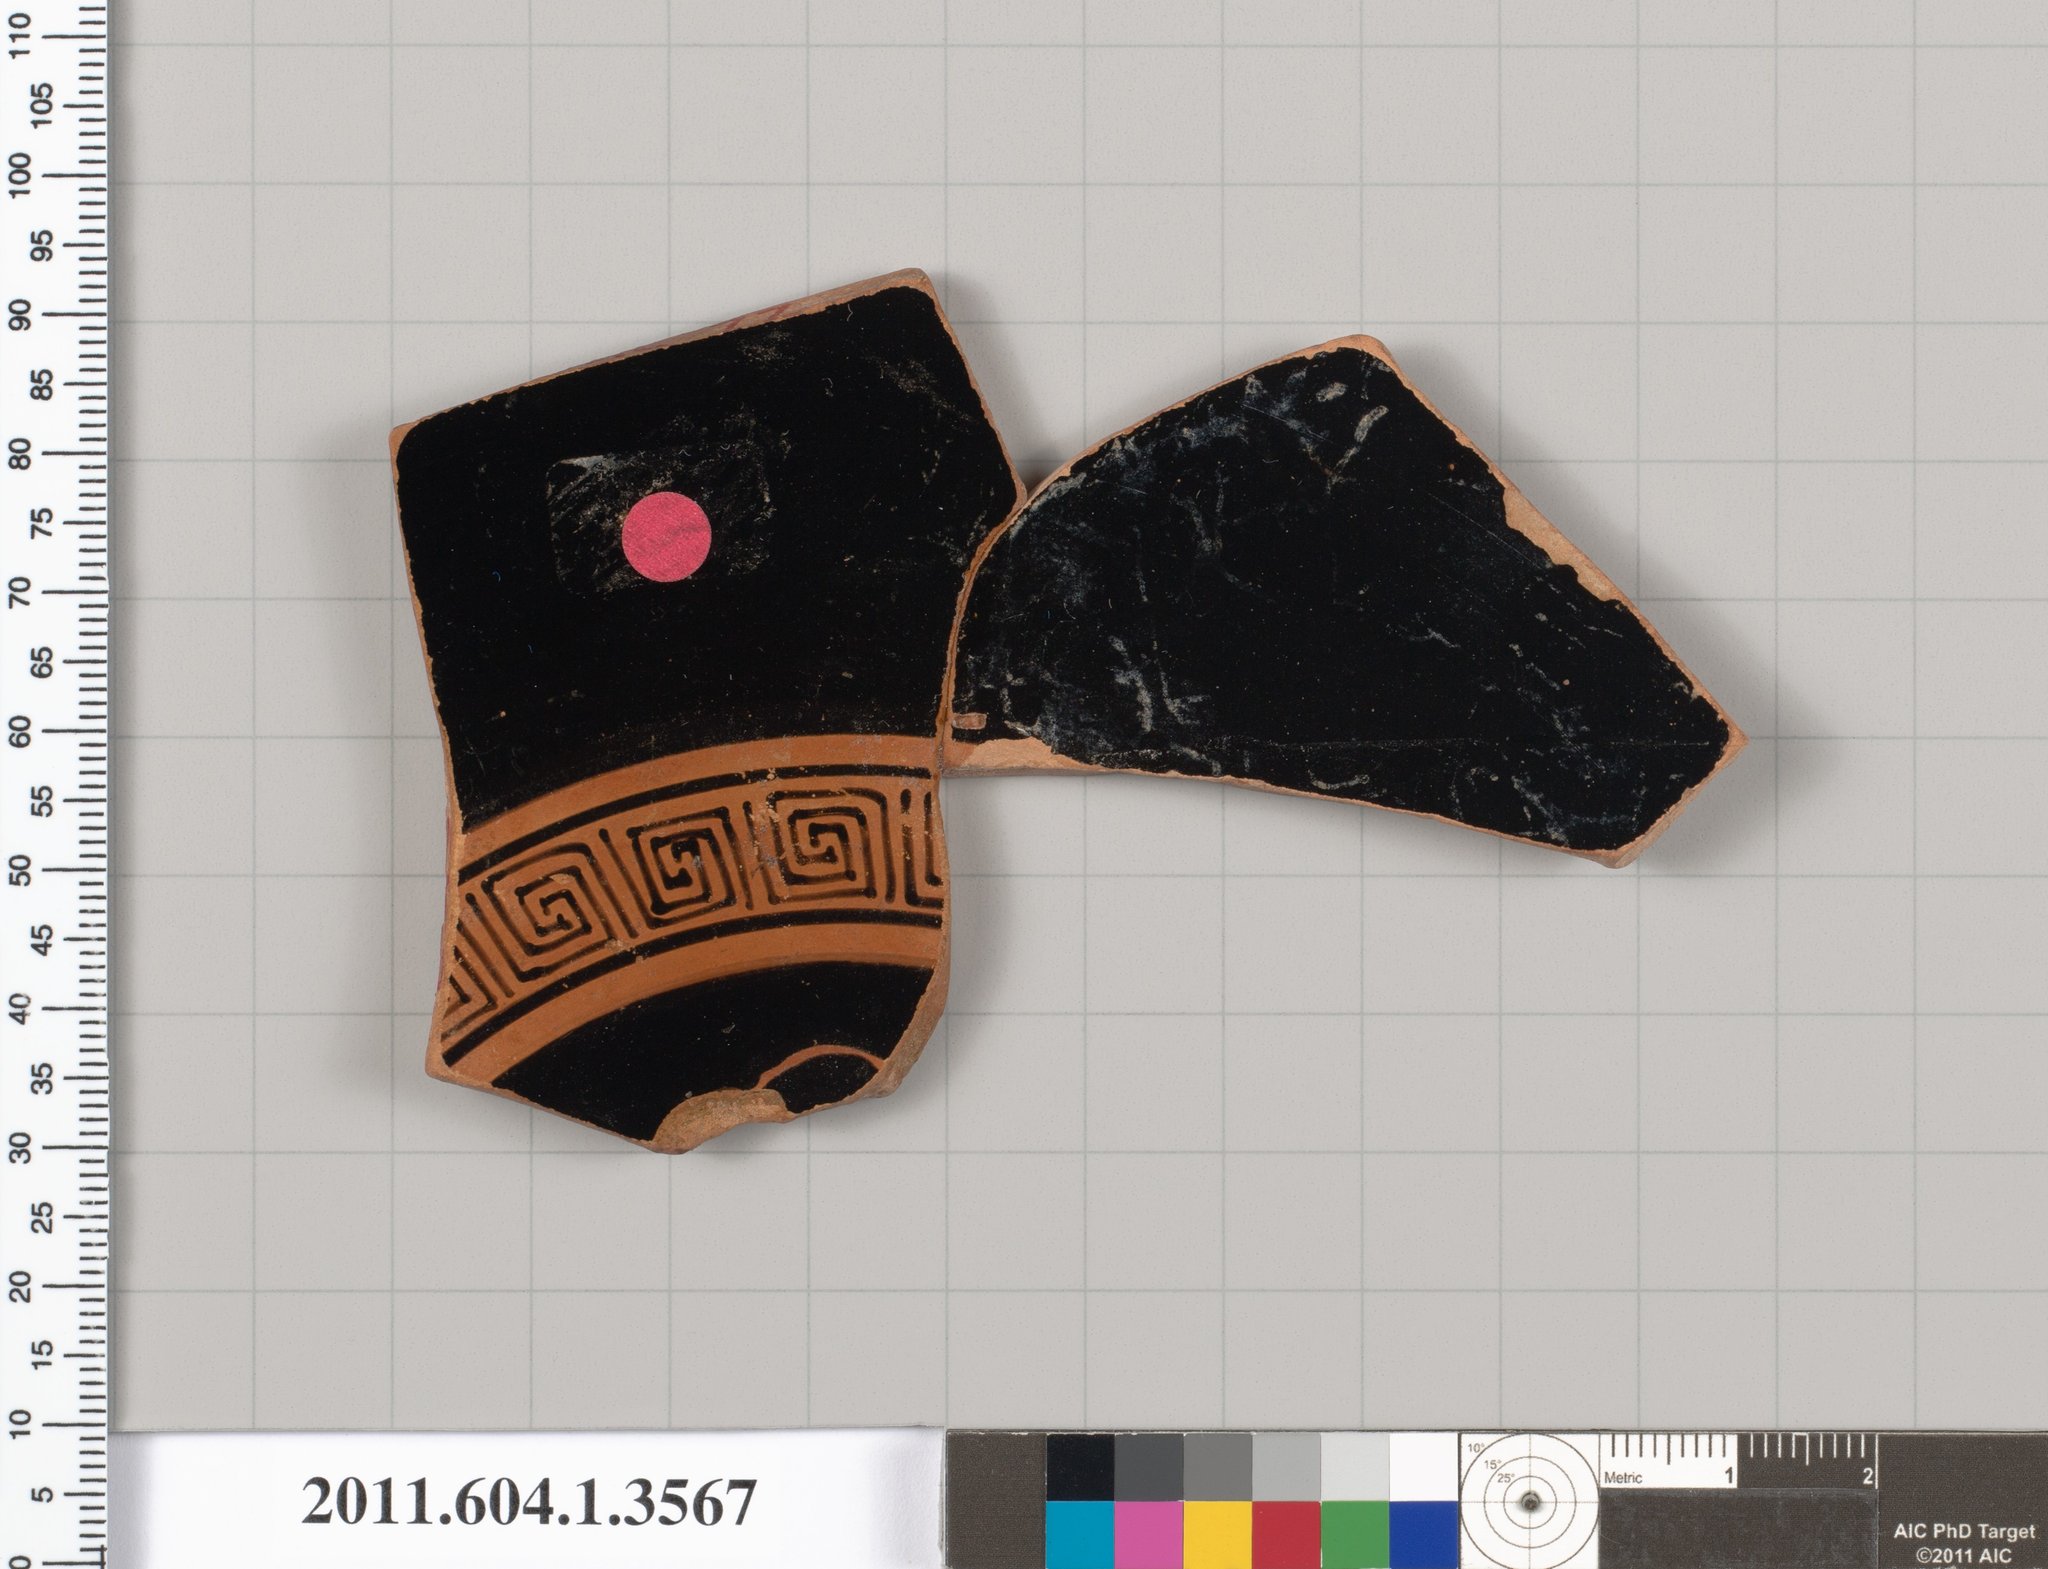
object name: kylix fragment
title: Terracotta fragment of a kylix (drinking cup)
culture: greek, attic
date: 475-451 BCE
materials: terracotta